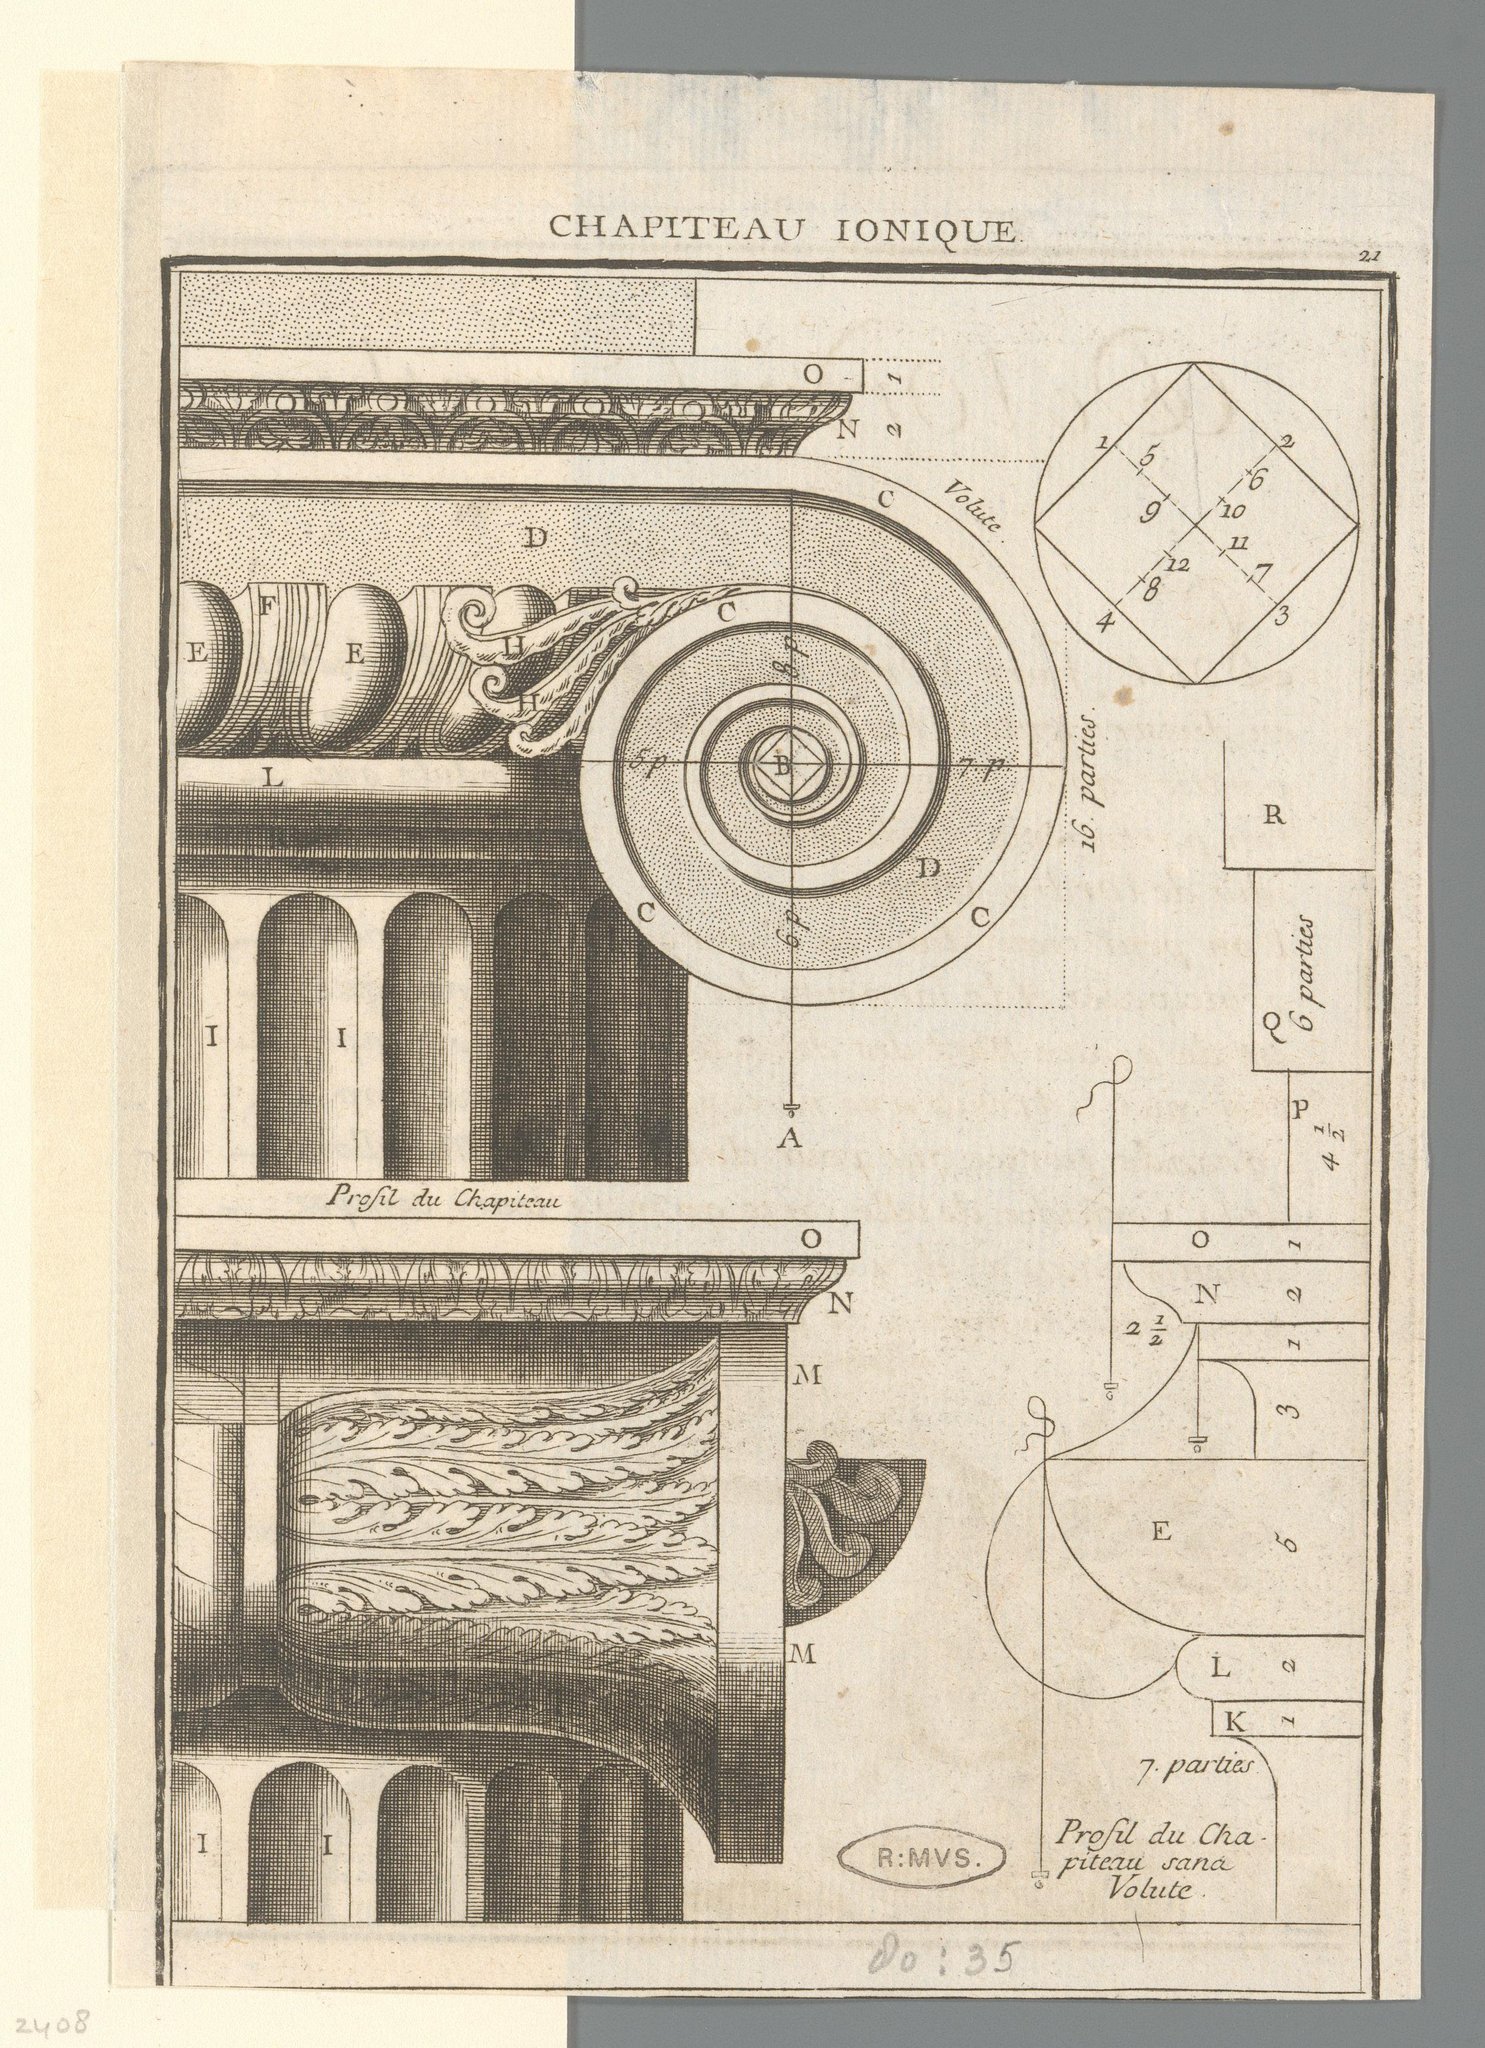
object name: print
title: Ionisch kapiteel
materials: paper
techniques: etching, letterpress printing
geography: paris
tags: ionic order ~ architecture, capital (~ column, pillar)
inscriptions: collector's mark: Lugt 2228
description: Pagina 21 uit: Babel, Pierre Edme. Le Nouveau Vignole ou Regles Des Cinq Ordres D'Architecture (...). Parijs: Chereau, François (II), 1755.